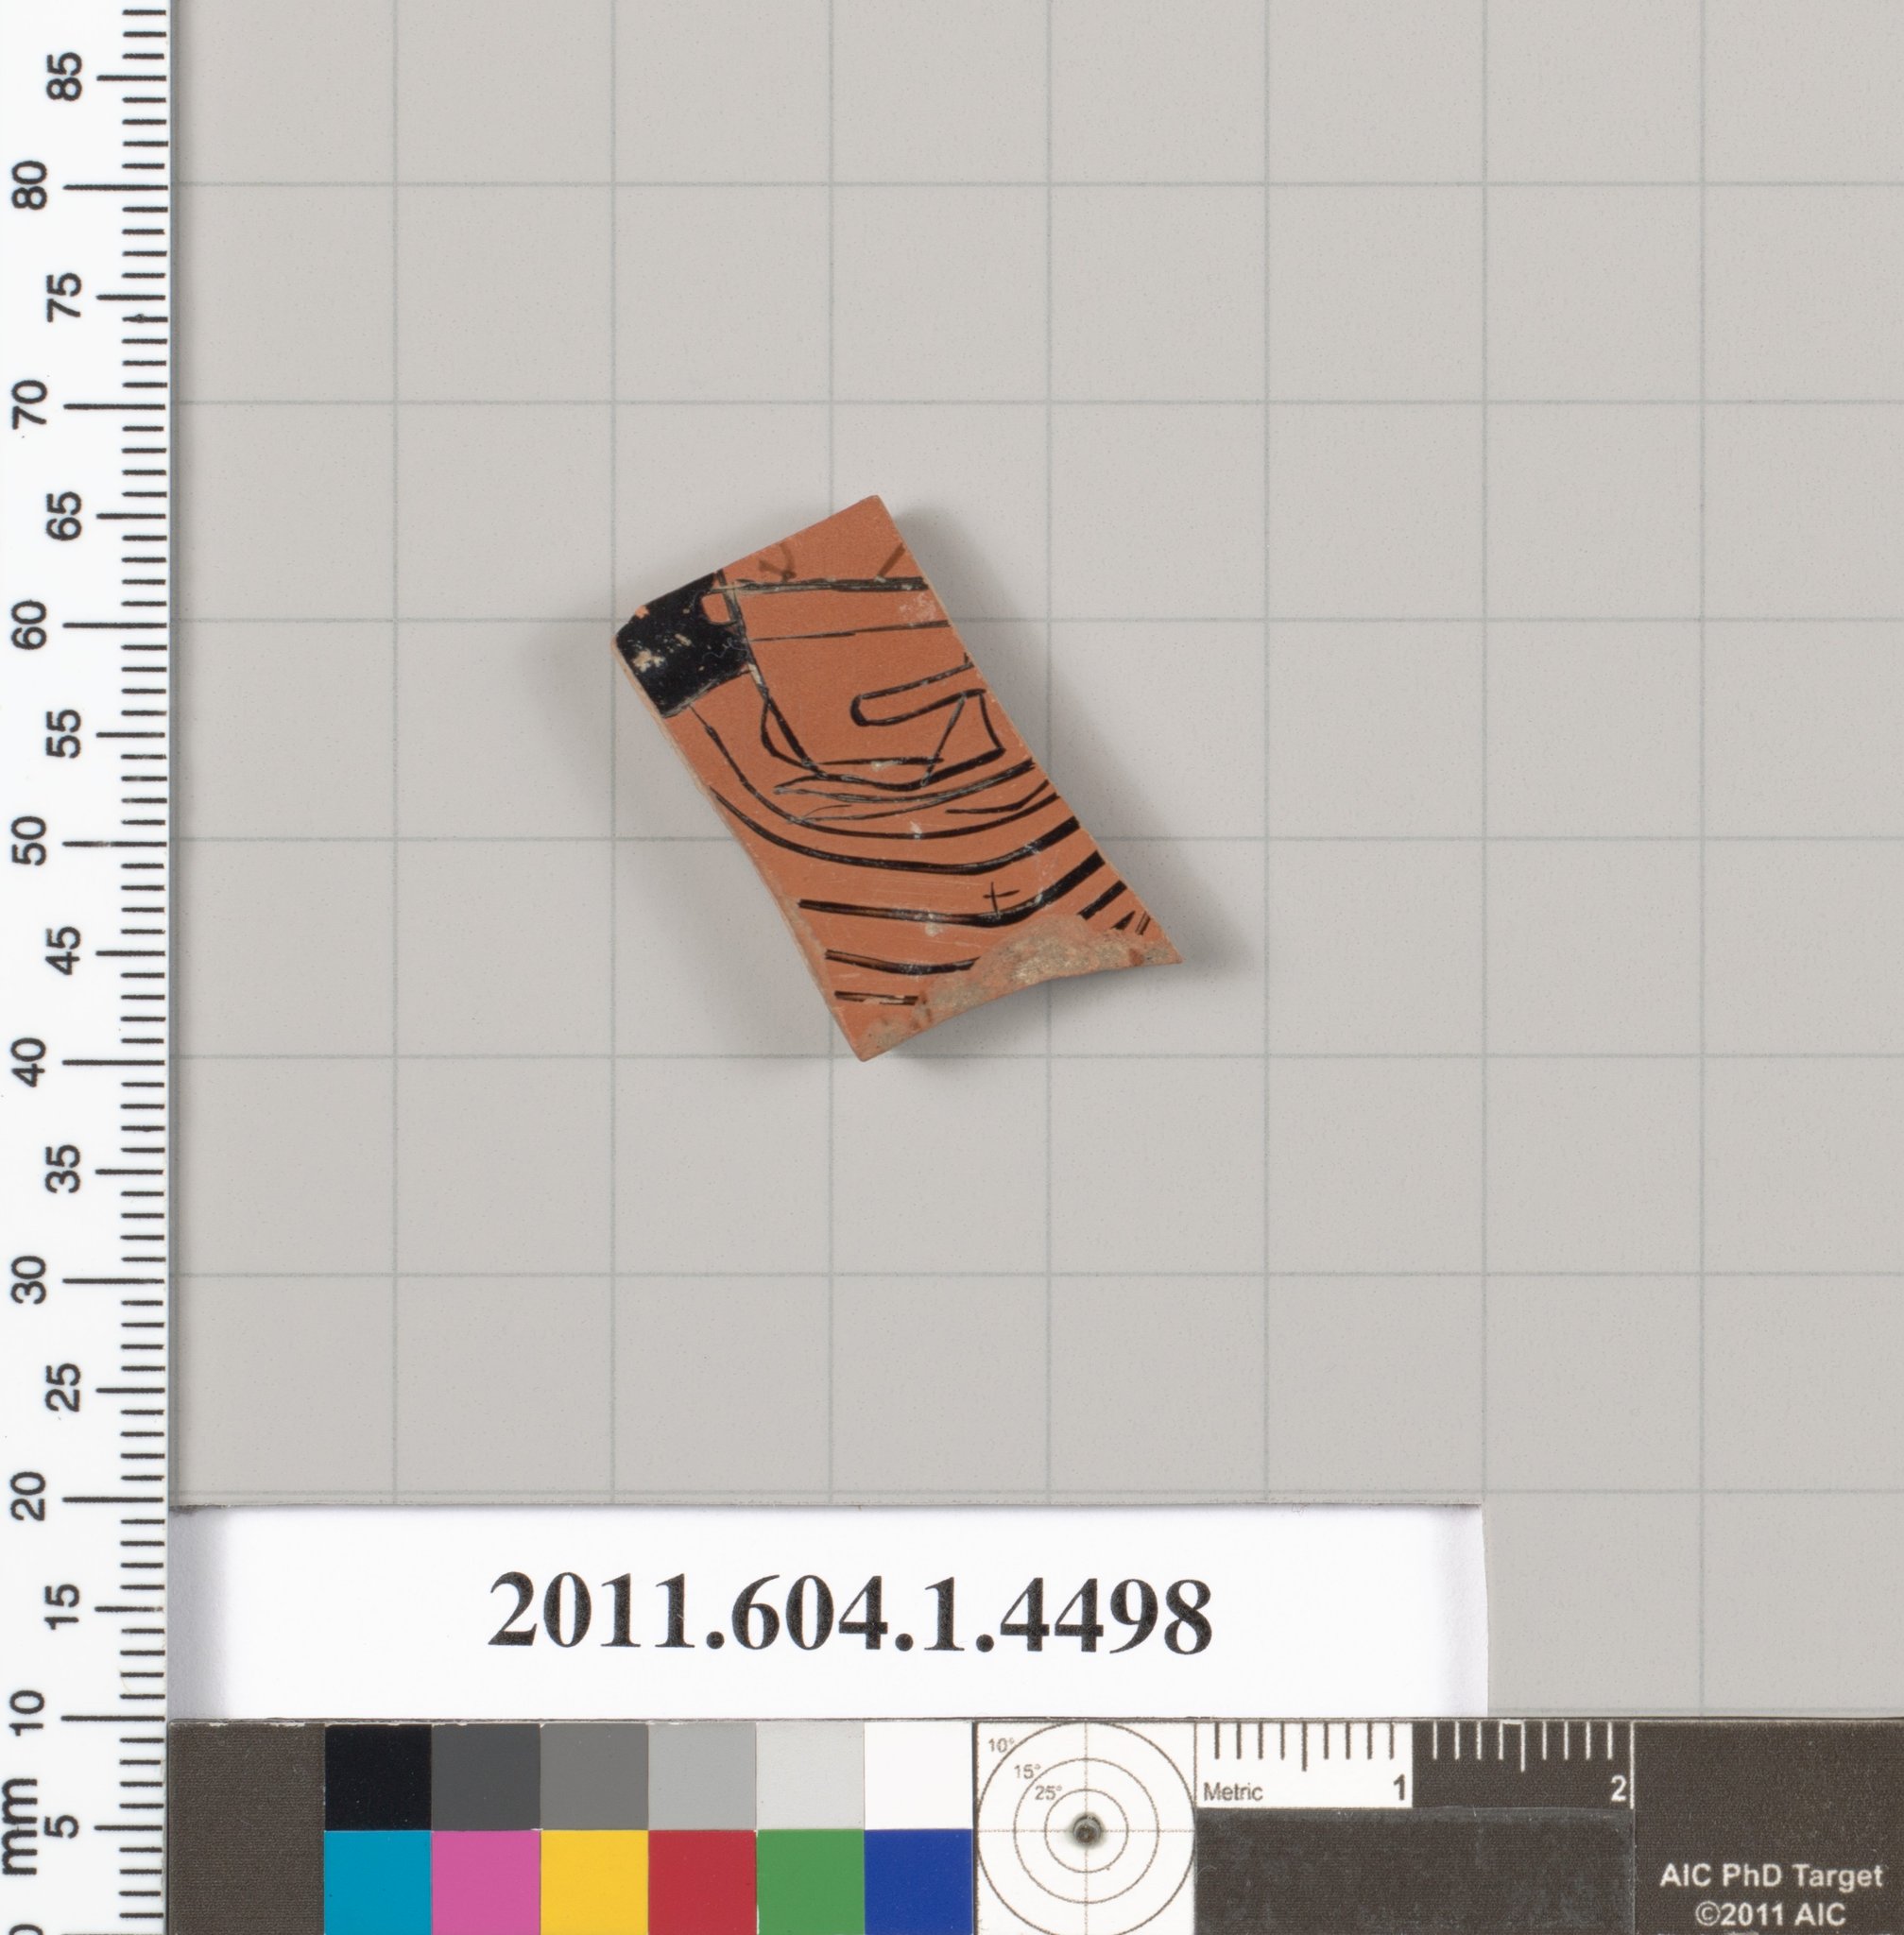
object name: kylix fragment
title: Terracotta fragment of a kylix (drinking cup)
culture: greek, attic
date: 490-470 BCE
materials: terracotta